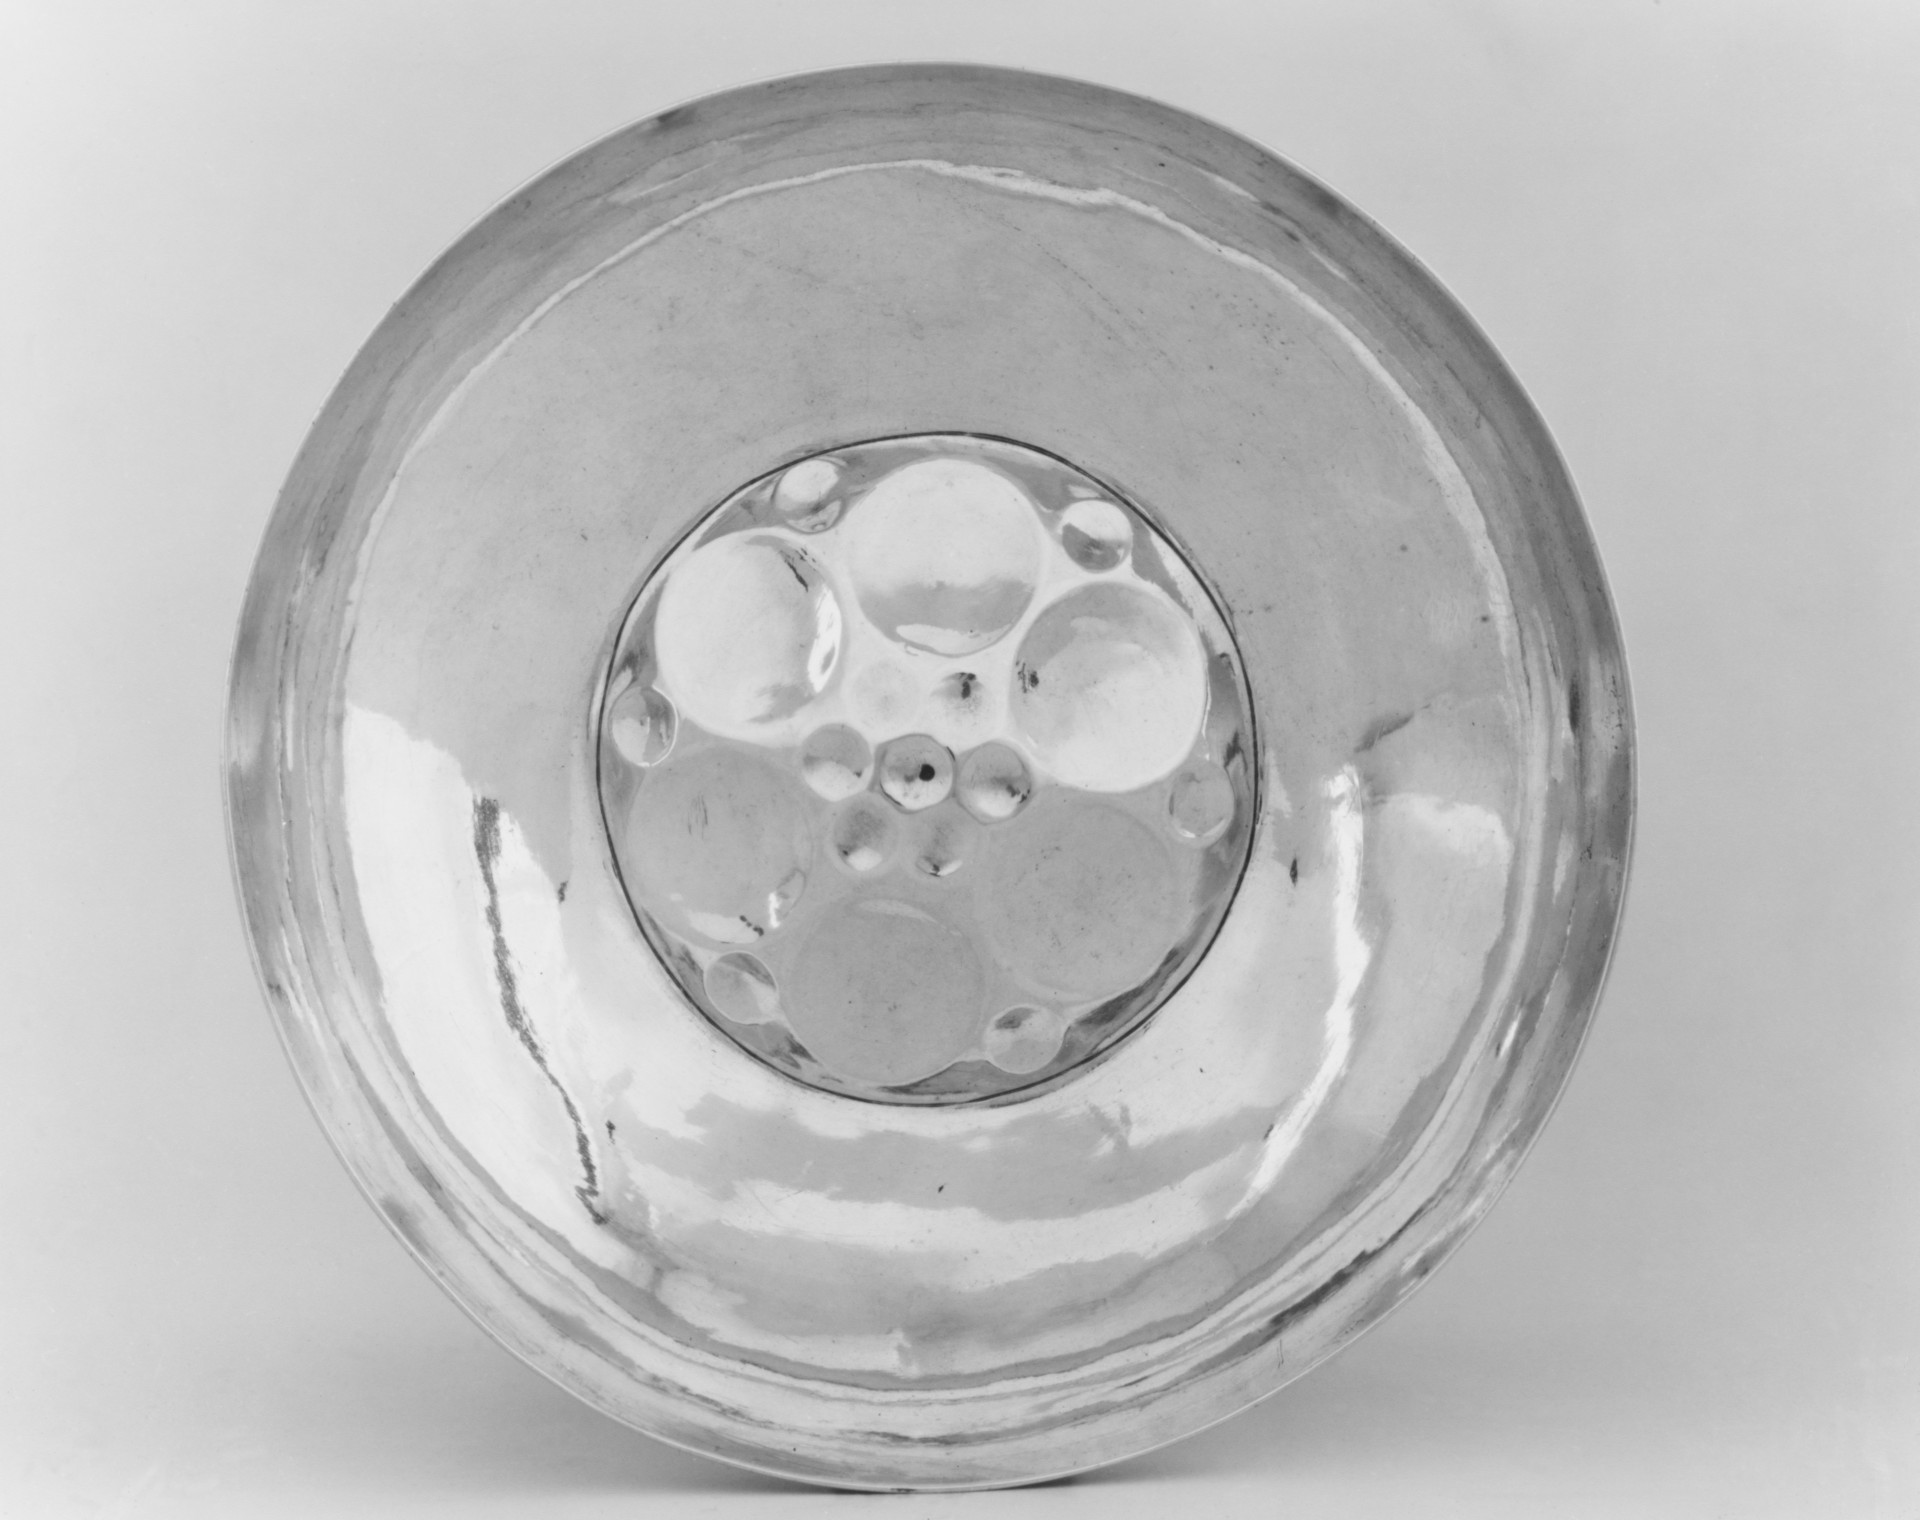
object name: bowl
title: Bowl (one of a pair)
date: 1451-1500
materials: gilt, silver